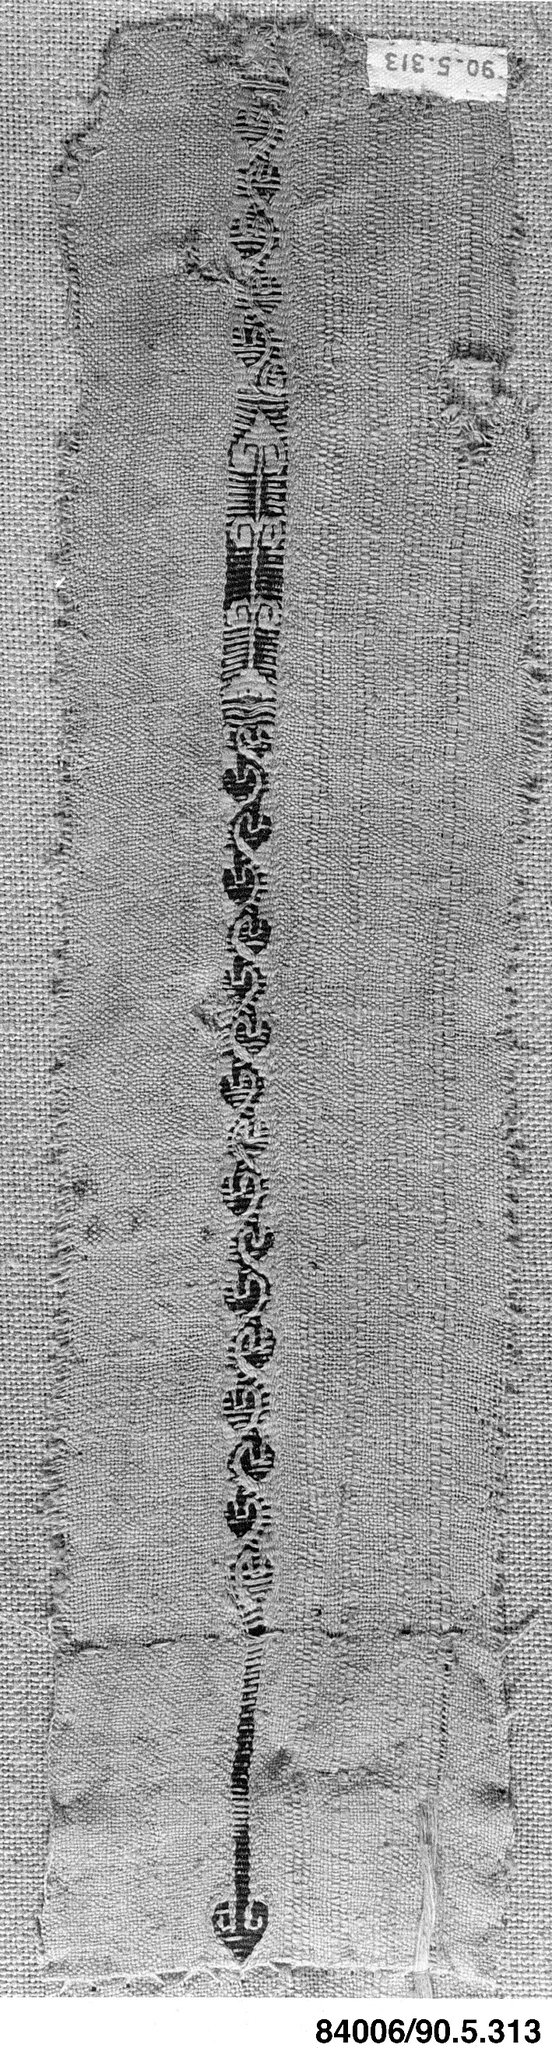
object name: textile fragment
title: Fragment of a Tunic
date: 201-400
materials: linen, wool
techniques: weave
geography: egypt